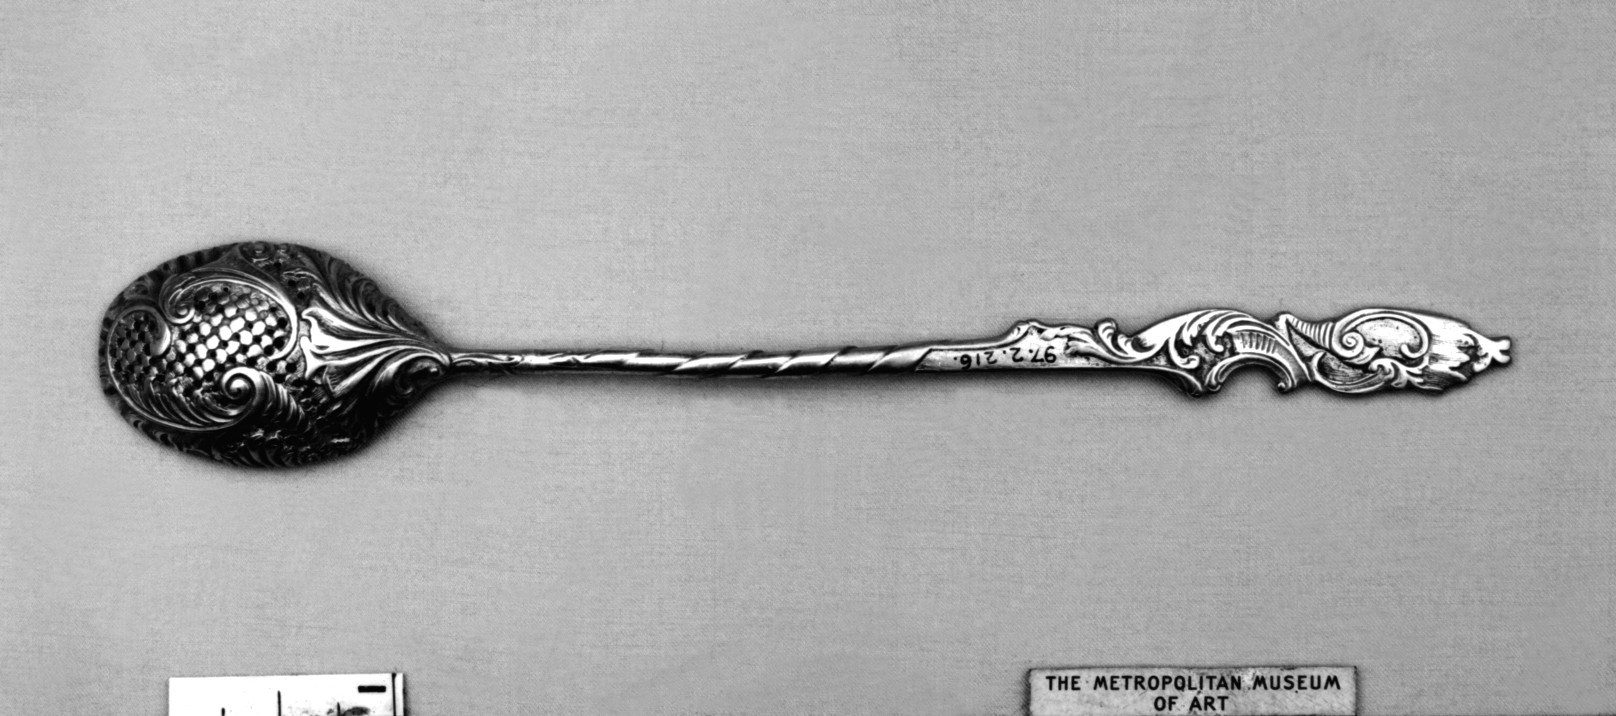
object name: spoon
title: Skimmer spoon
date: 1801-1900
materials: gilt, silver